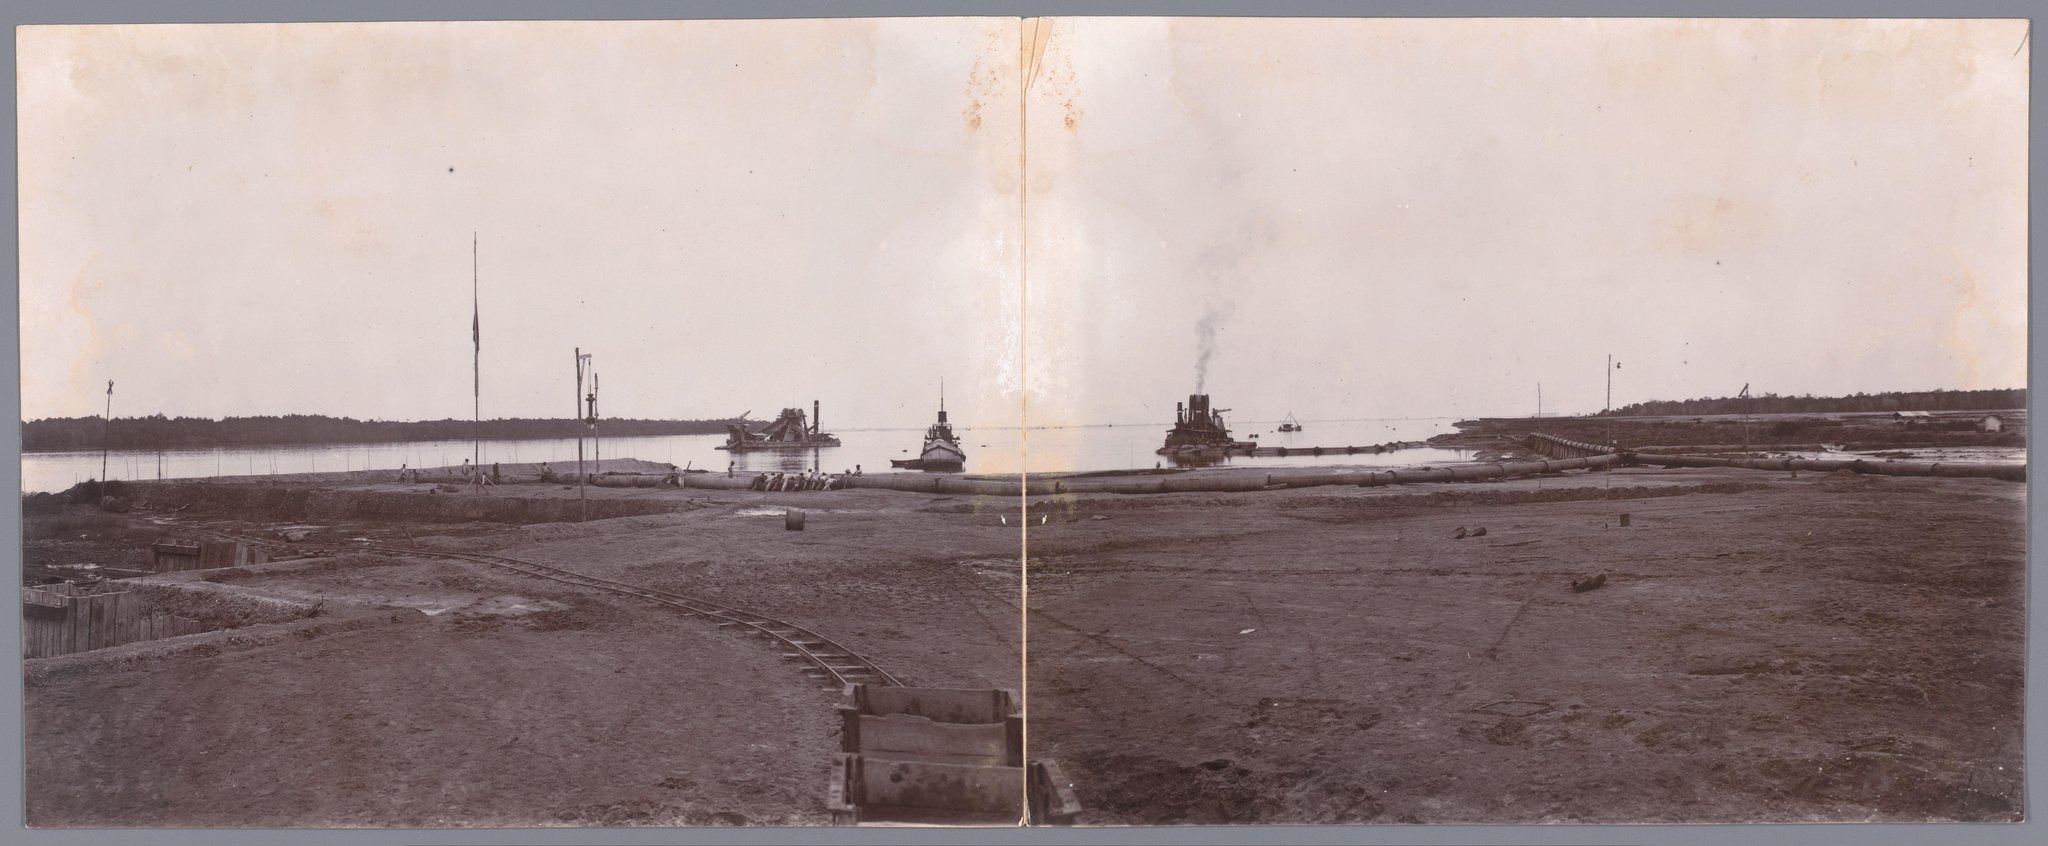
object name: photograph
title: Oceaanhaven Belawan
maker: Anonymous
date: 1922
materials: photographic support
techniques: gelatin silver print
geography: belawan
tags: harbour, building-site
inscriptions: inscription: ‘No. 132 Oceaanhaven Belawan / Opspuiten van de zandbelasting door ss Madjoe 1e werk’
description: Opspuiten van zand door de SS Madjoe. Twee foto's aan elkaar geplakt. Genummerd: 132. Onderdeel van de groep van losse foto's over de aanleg van de haven Belawan aan de kust voor Medan, Sumatra 1921-1922.